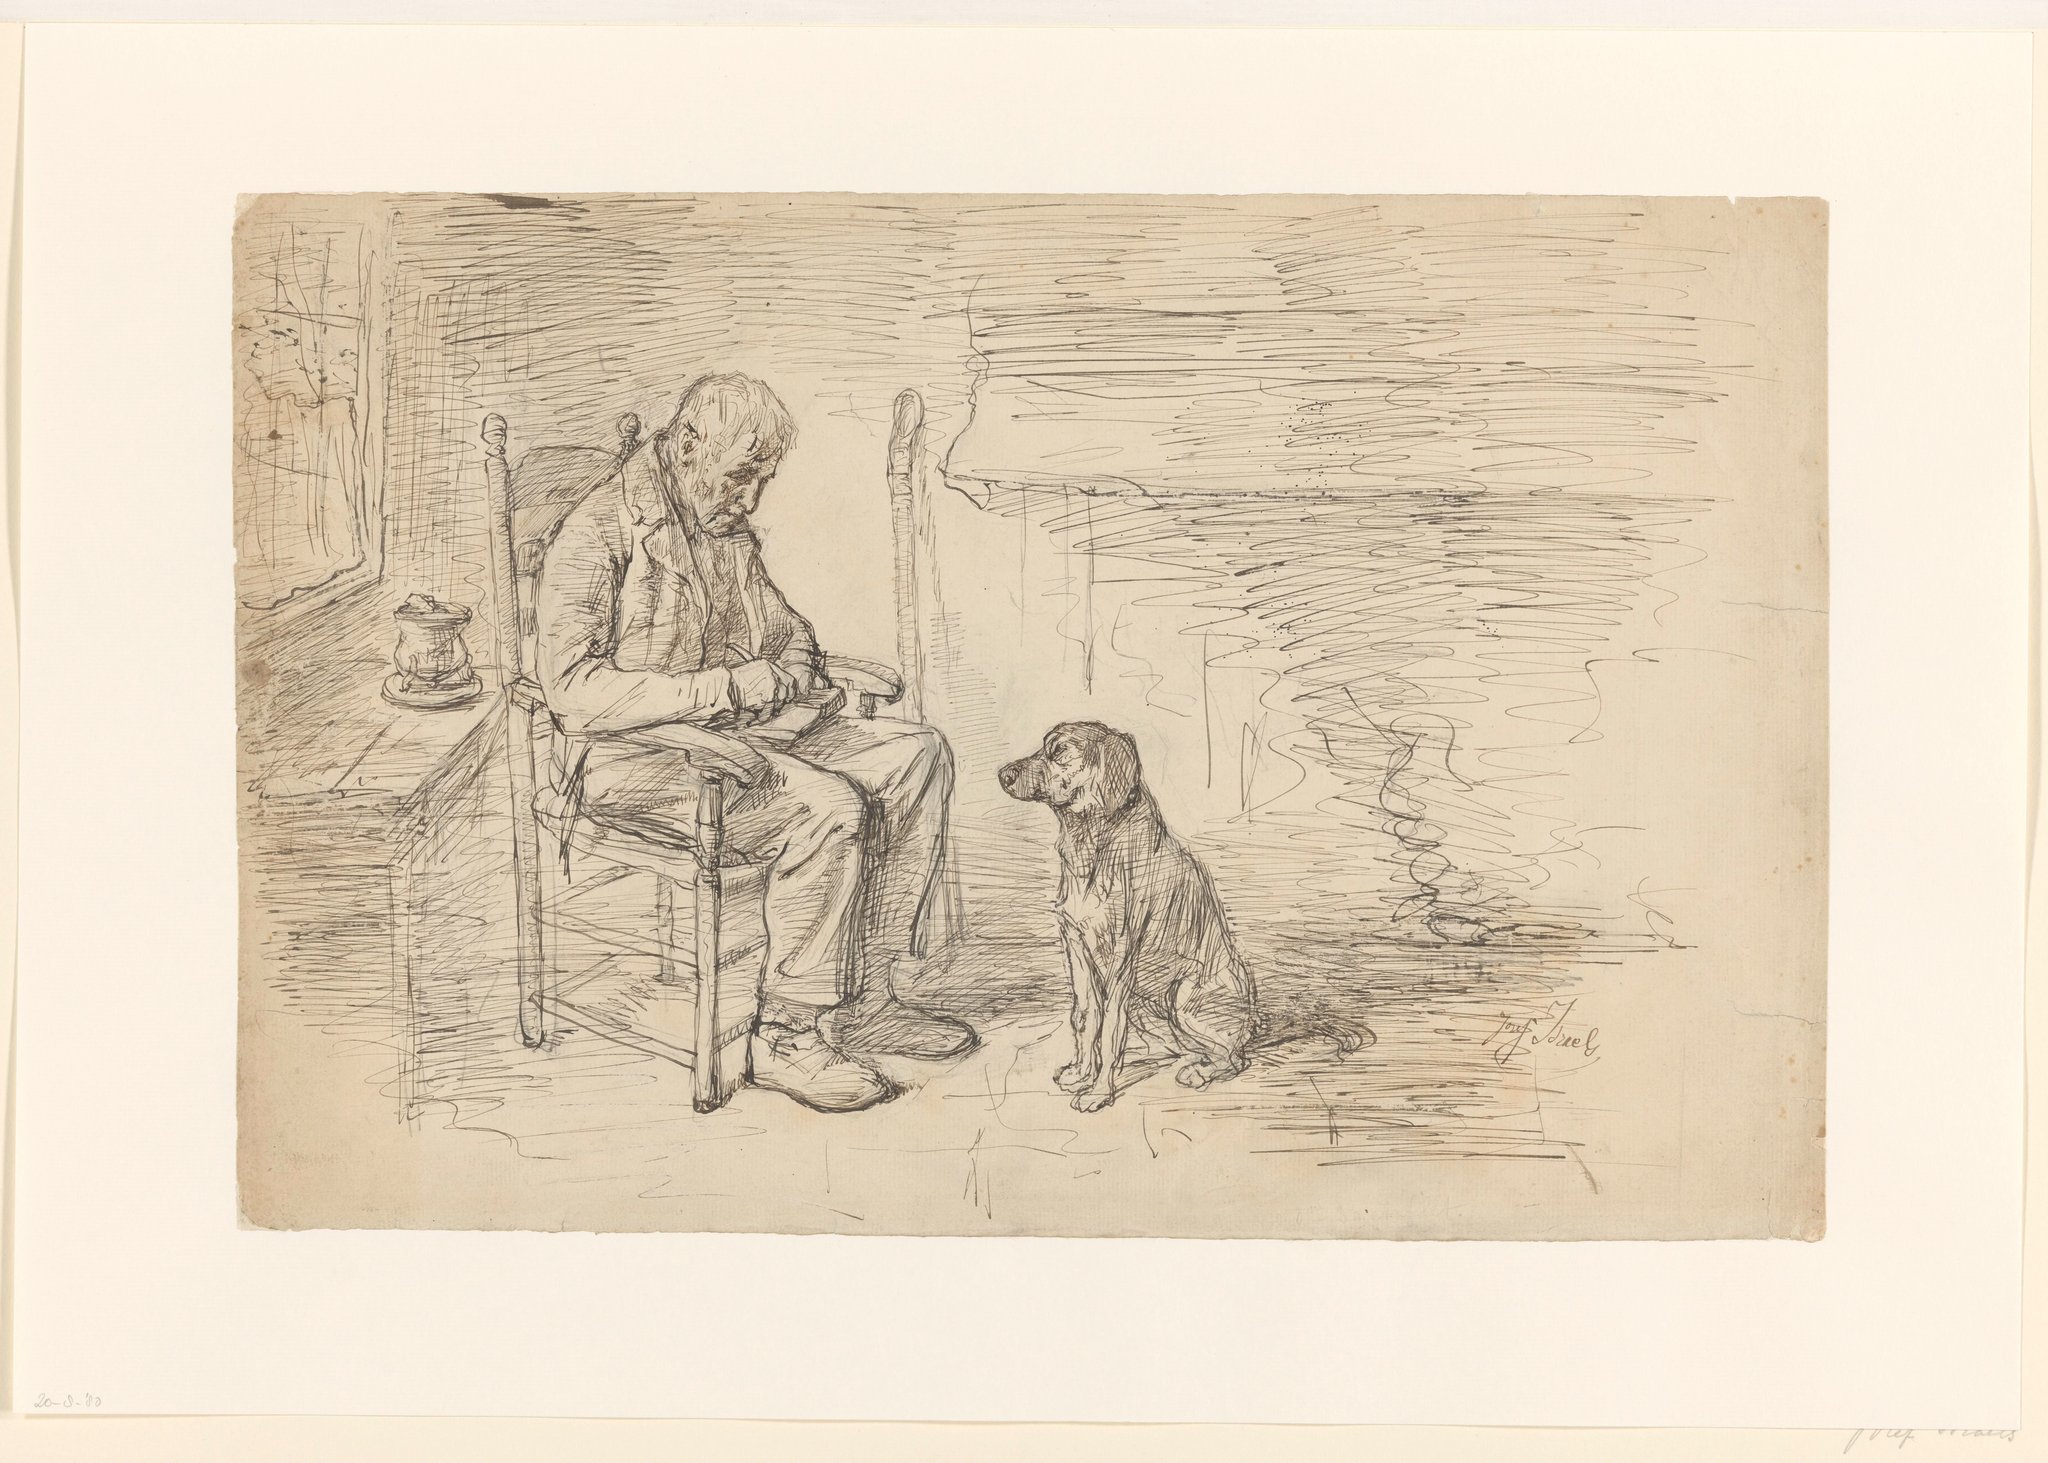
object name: drawing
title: Zittende man met hond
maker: jozef israëls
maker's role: draughtsman, painter, print maker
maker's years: 1824-1911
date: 1834-1911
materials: ink, paper, pencil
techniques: pen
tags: communal rooms, dog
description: 'Entretien silencieux' (Twee kameraden / De goede kameraden).